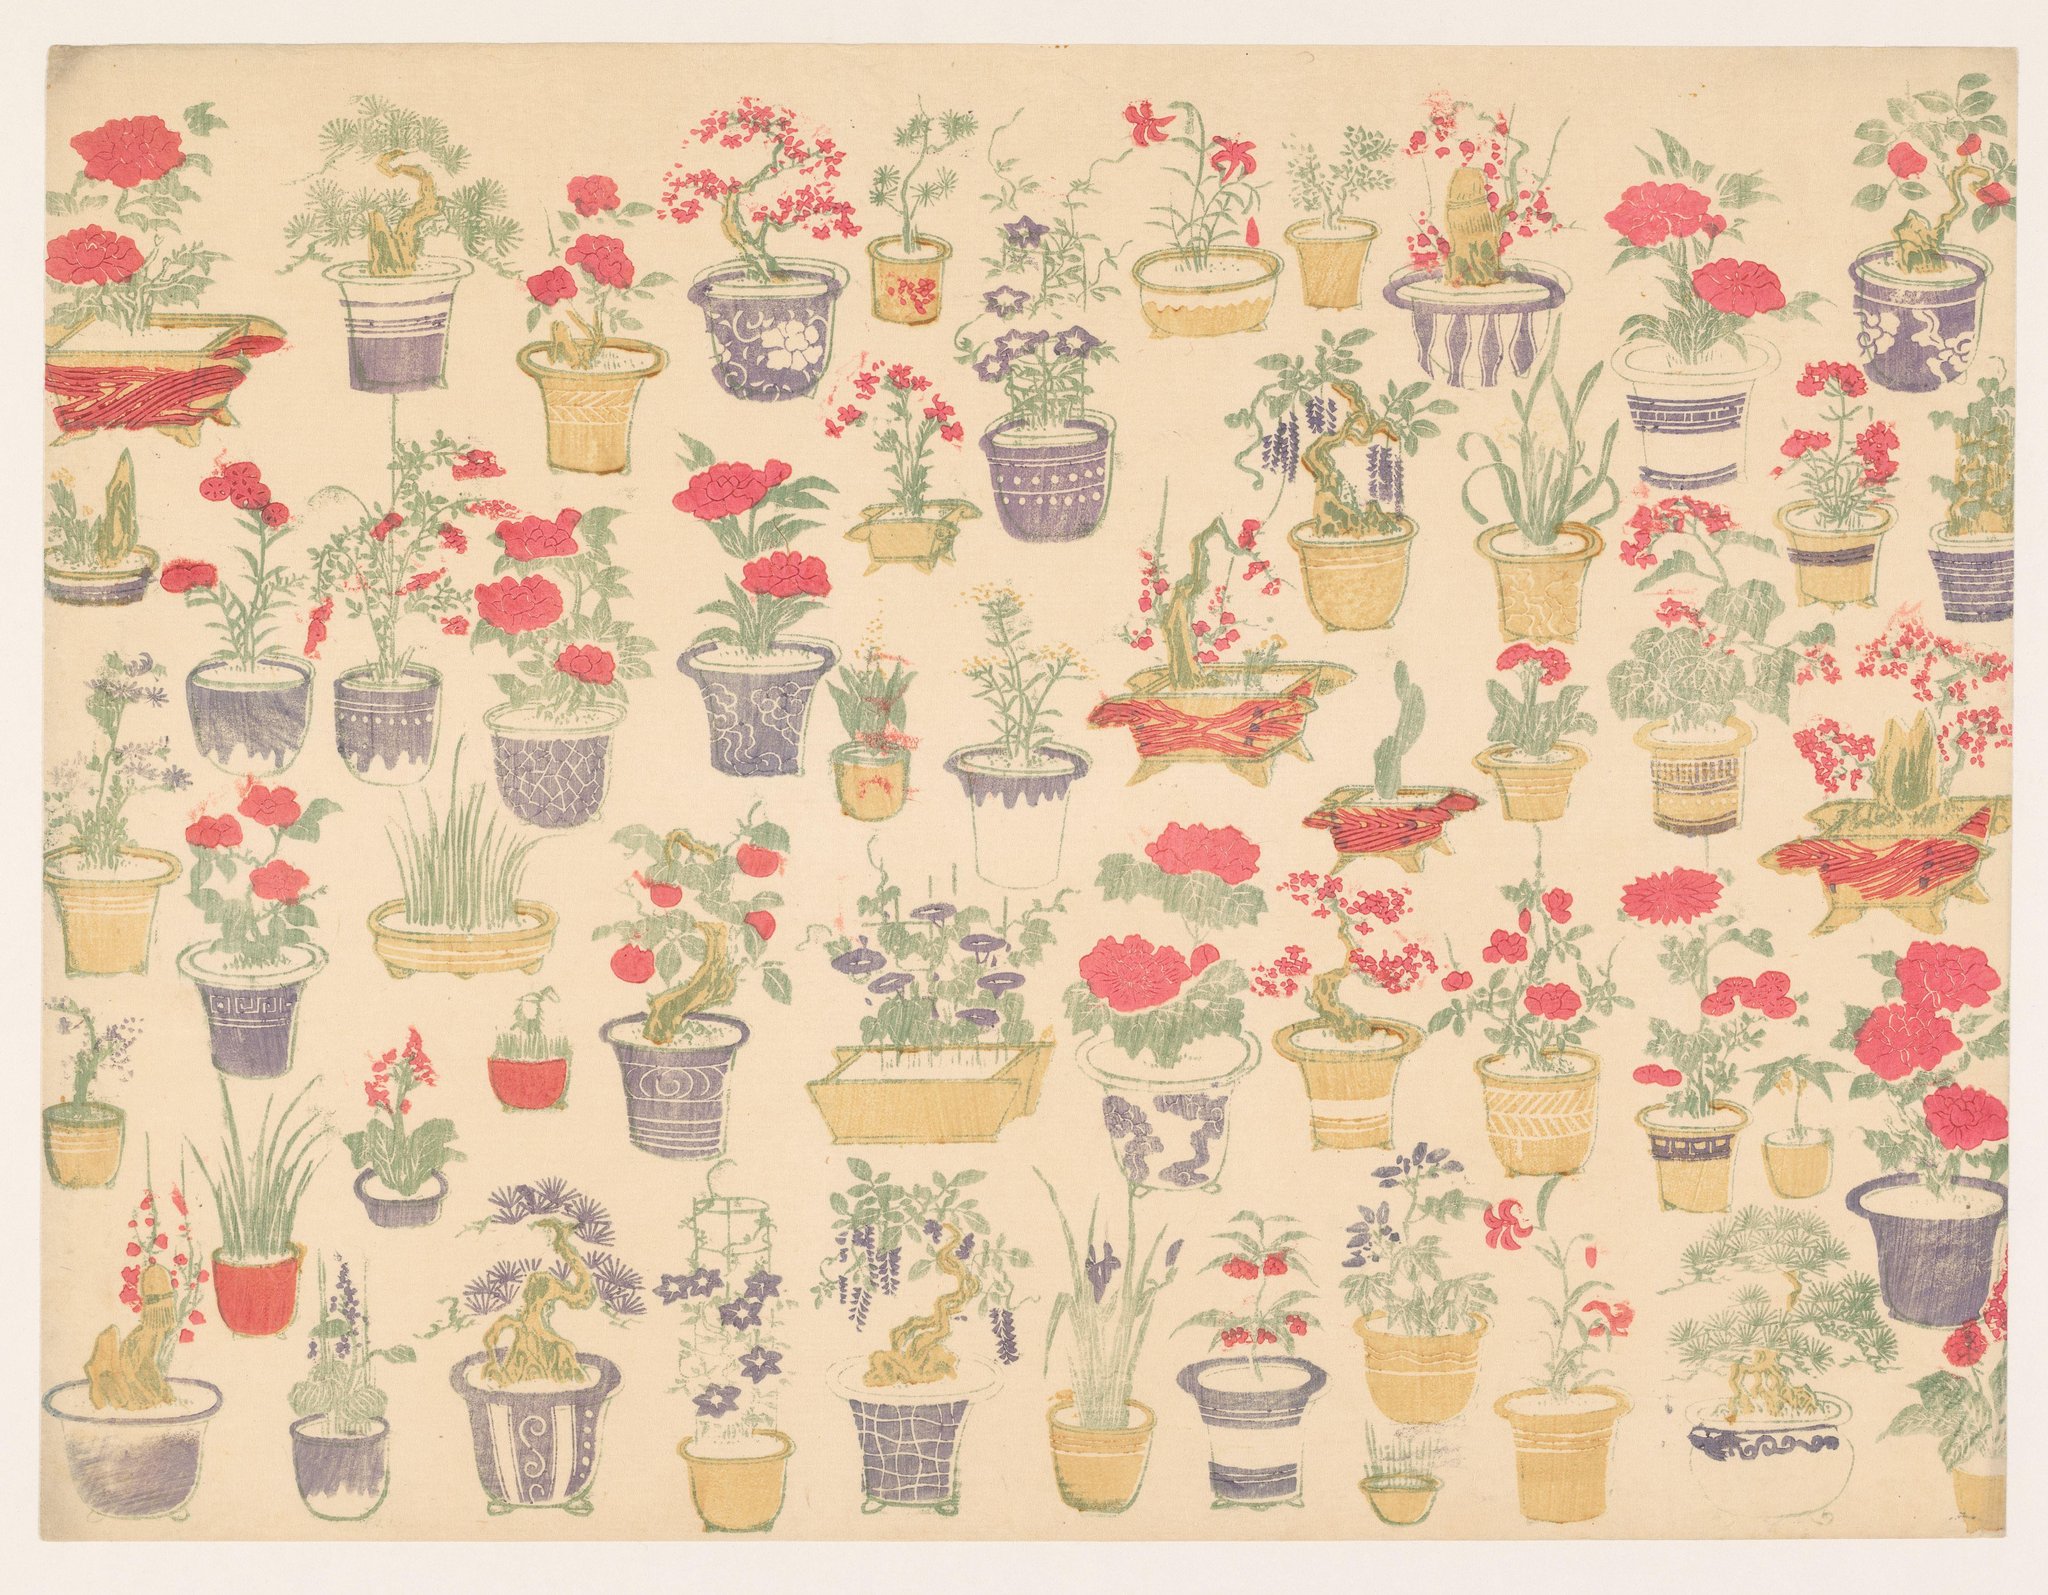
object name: decorated paper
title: Patroon van potten met verschillende planten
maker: Anonymous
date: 1860-1930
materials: paper, paint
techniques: woodcut, printing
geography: japan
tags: potted plants, ornament derived from plant forms